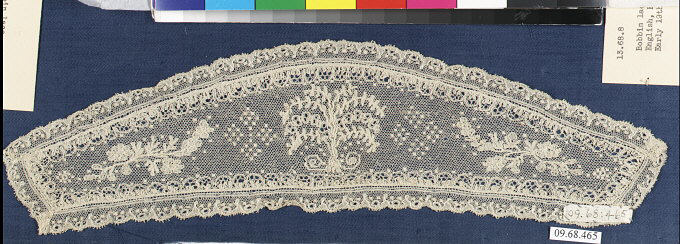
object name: cuff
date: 1801-1900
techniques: lace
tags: flowers,trees